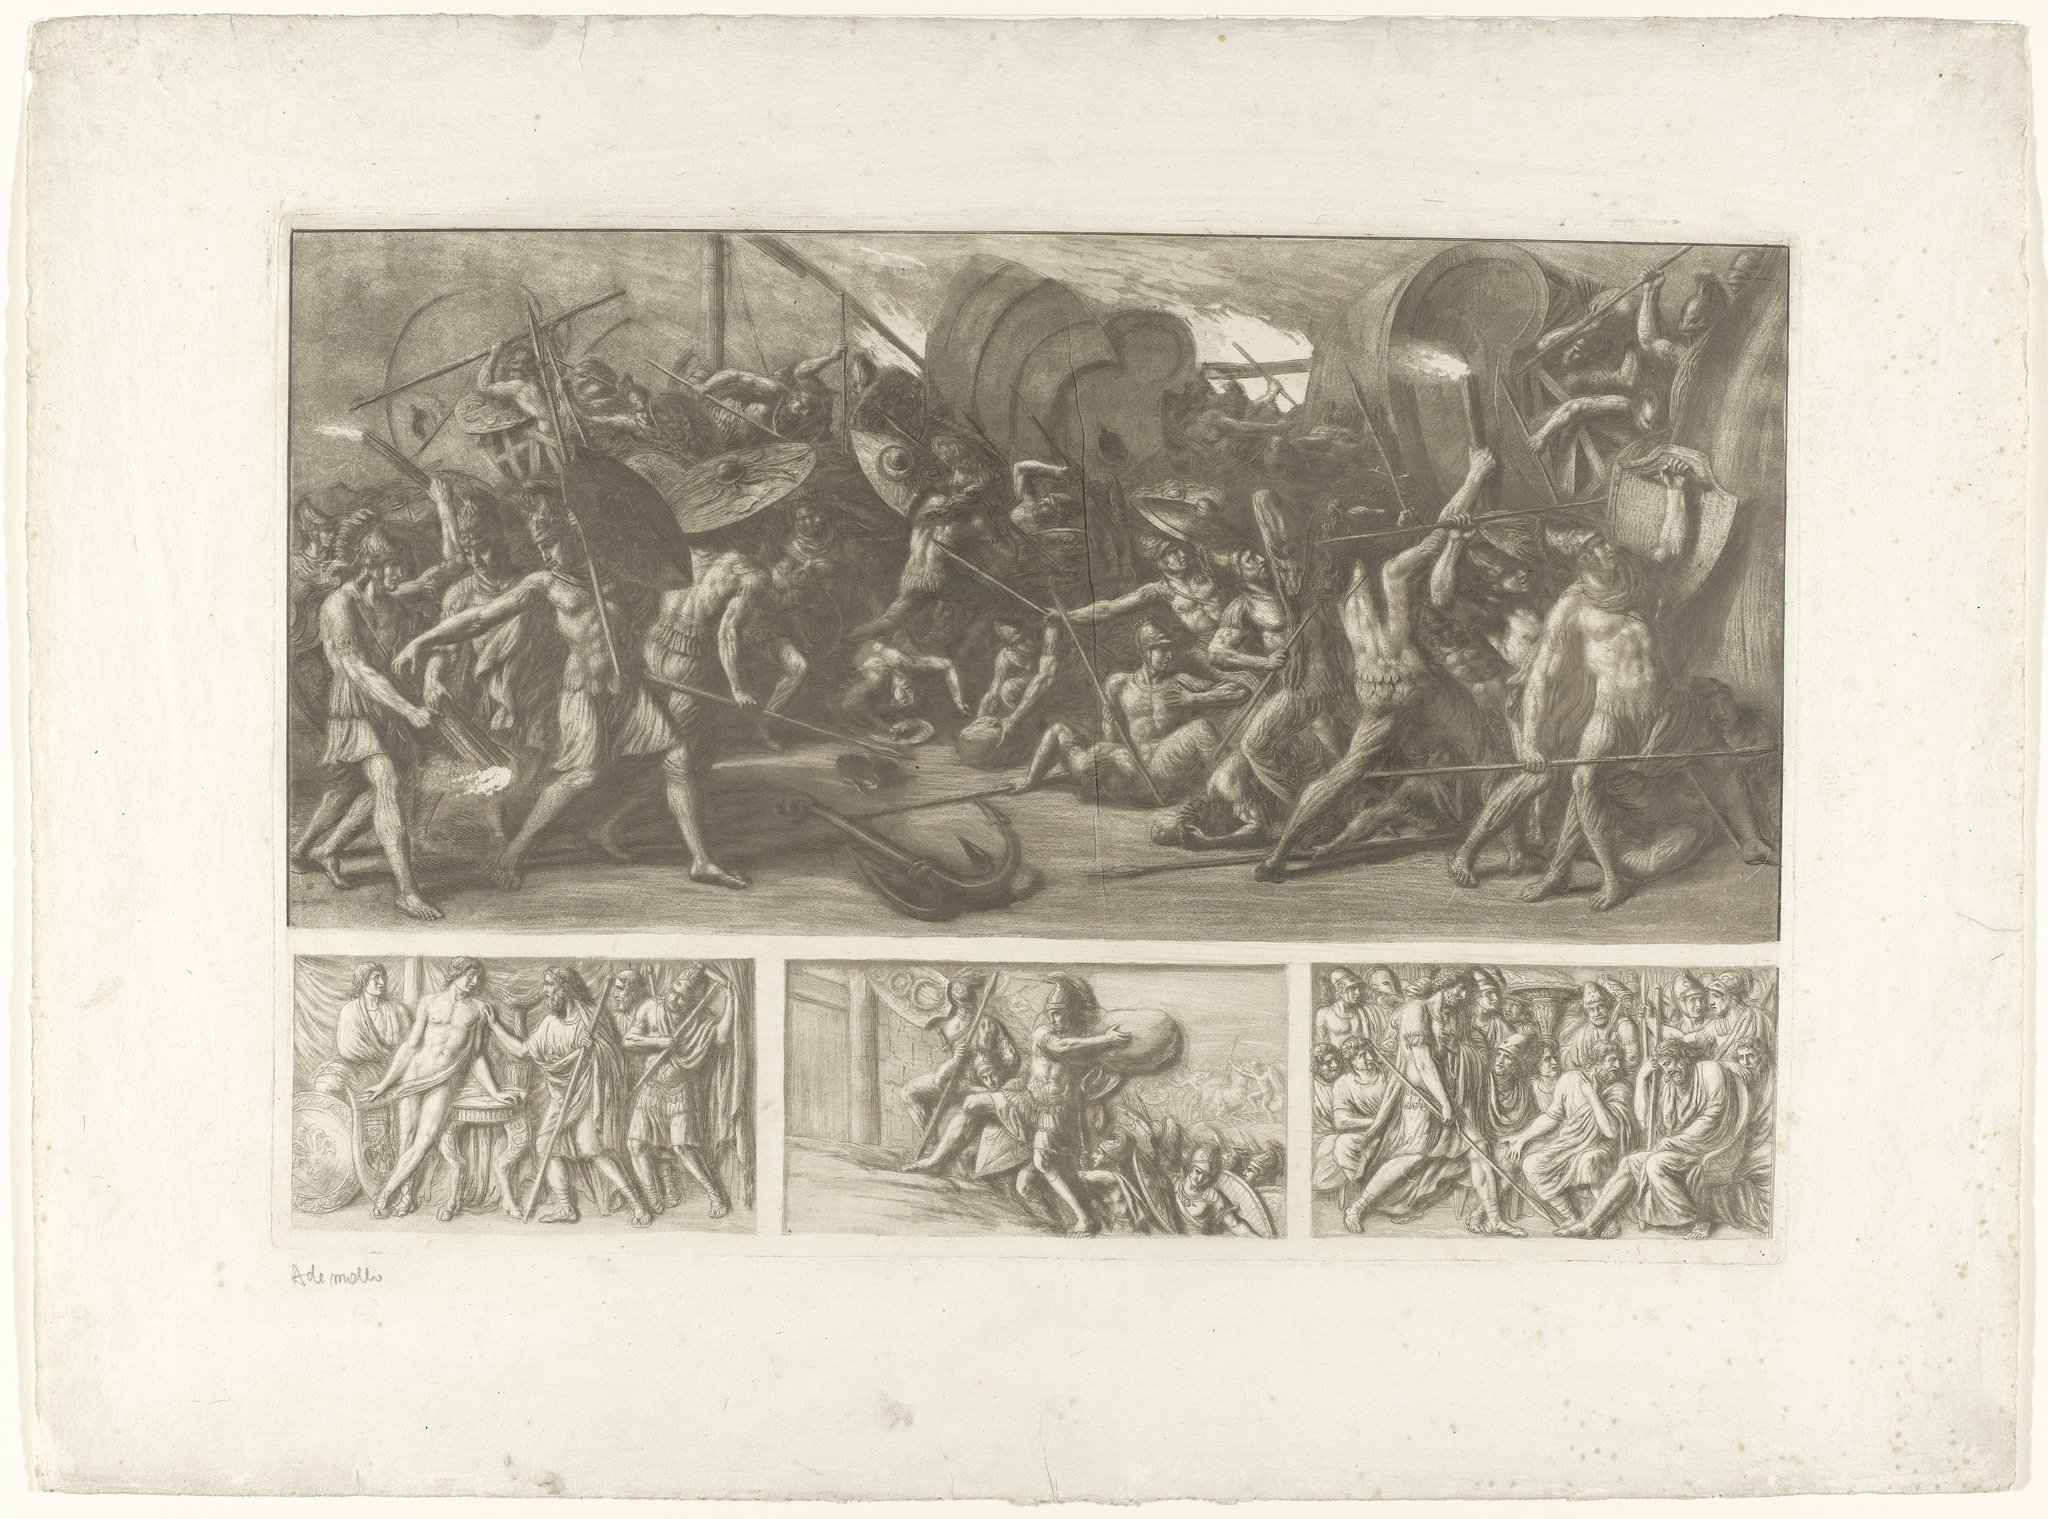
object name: print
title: Vier scènes uit de Trojaanse Oorlog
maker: luigi ademollo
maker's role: draughtsman, painter, print maker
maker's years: 1764-1849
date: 1774-1849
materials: paper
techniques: aquatint, etching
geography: italy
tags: the trojan war: the first nine years of the war, the trojan war (94c - 94h), battle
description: Boven een grote voorstelling van soldaten strijdend in de Trojaanse Oorlog. Onder drie kleinere scènes.